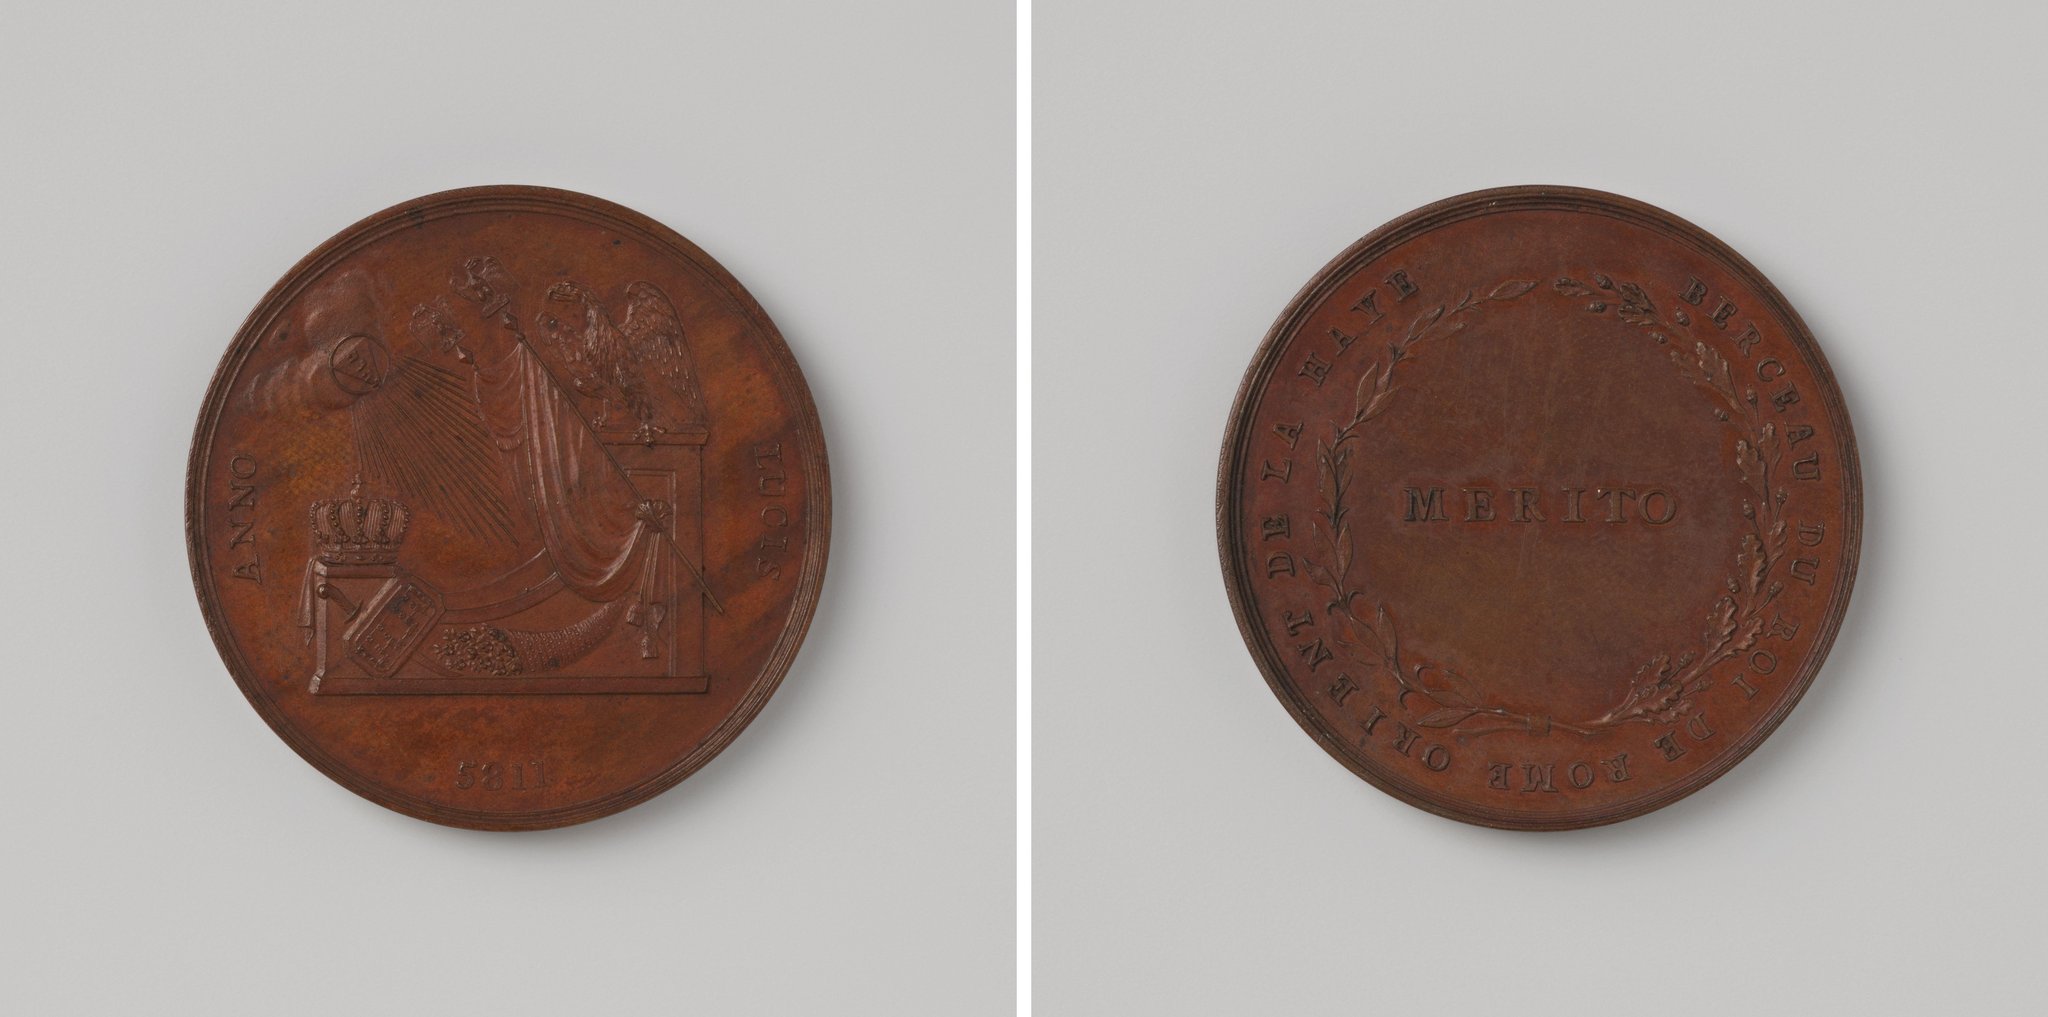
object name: history medal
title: Stichting van de loge "Berceau du Roi de Rome" te 's-Gravenhage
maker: Anonymous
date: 1811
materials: bronze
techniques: striking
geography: netherlands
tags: the hague